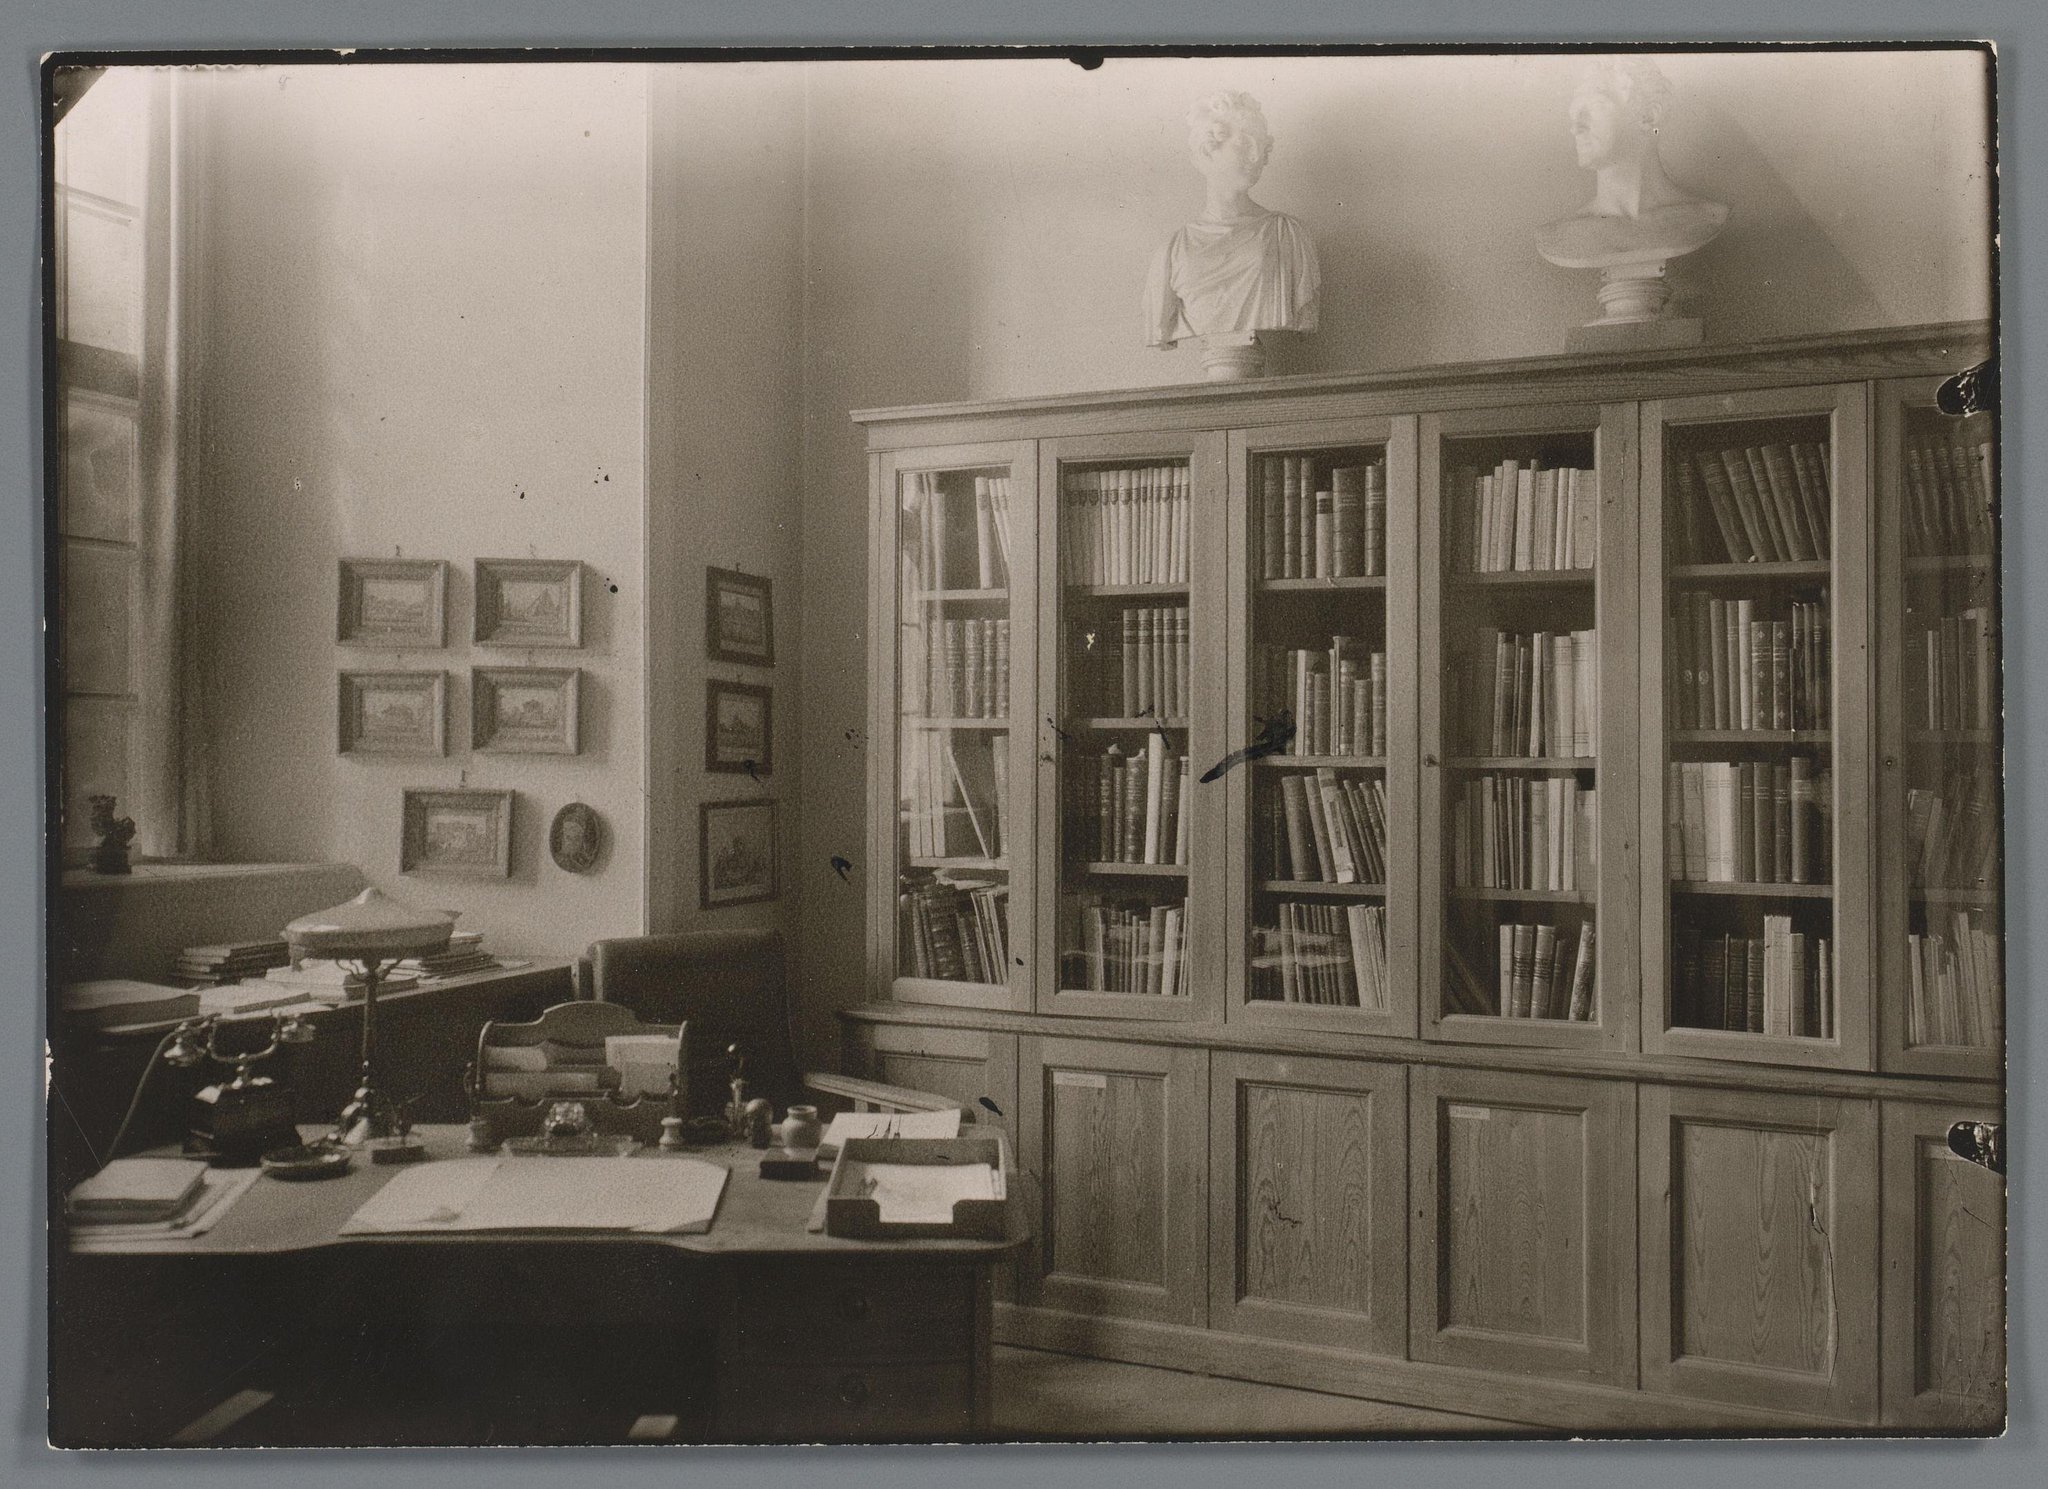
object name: photograph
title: Cabinet du professeur du Gustavianum à Upsal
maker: august hako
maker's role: fotograaf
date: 1934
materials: paper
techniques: gelatin silver print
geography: uppsala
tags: study; 'studiolo'; library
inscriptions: date: ‘handgeschreven’